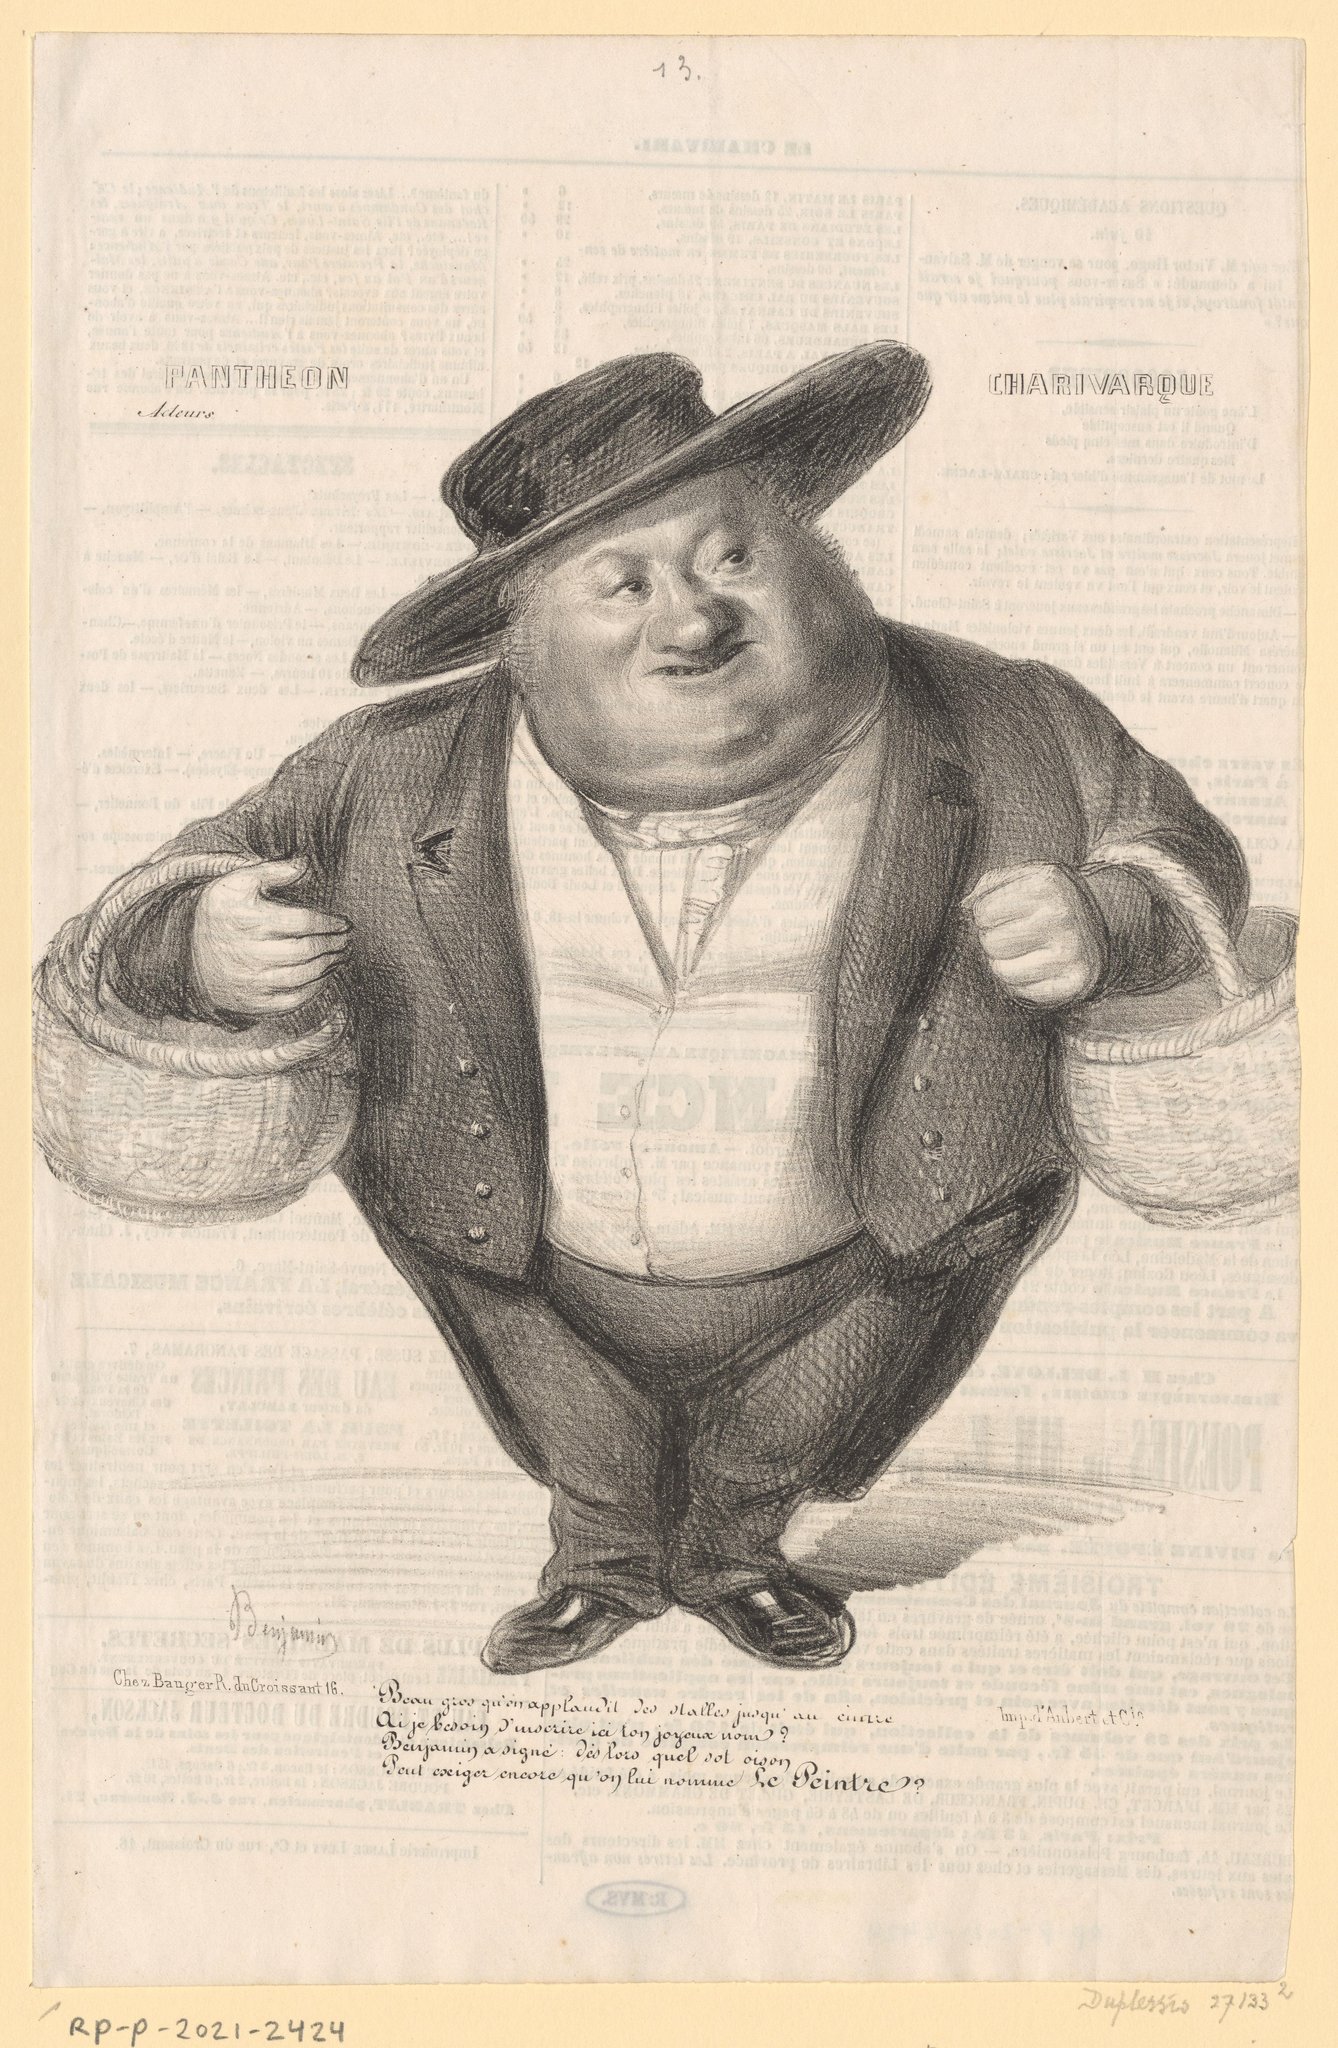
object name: cartoon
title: Panthéon Charivarique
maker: benjamin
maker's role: print maker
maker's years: 1811-1847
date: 1841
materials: paper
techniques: letterpress printing, lithograph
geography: france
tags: paris, caricatures (human types), historical persons, container made of plant material other than wood: basket, head-gear: hat, portrait of actor, actress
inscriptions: collector's mark: Lugt 2228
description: Uit de serie: Panthéon charivarique, bestaande uit 100 portretten van tekenaars, schrijvers, schilders, beeldhouwers, musici en acteurs. Prent uit: Le Charivari, 1841.